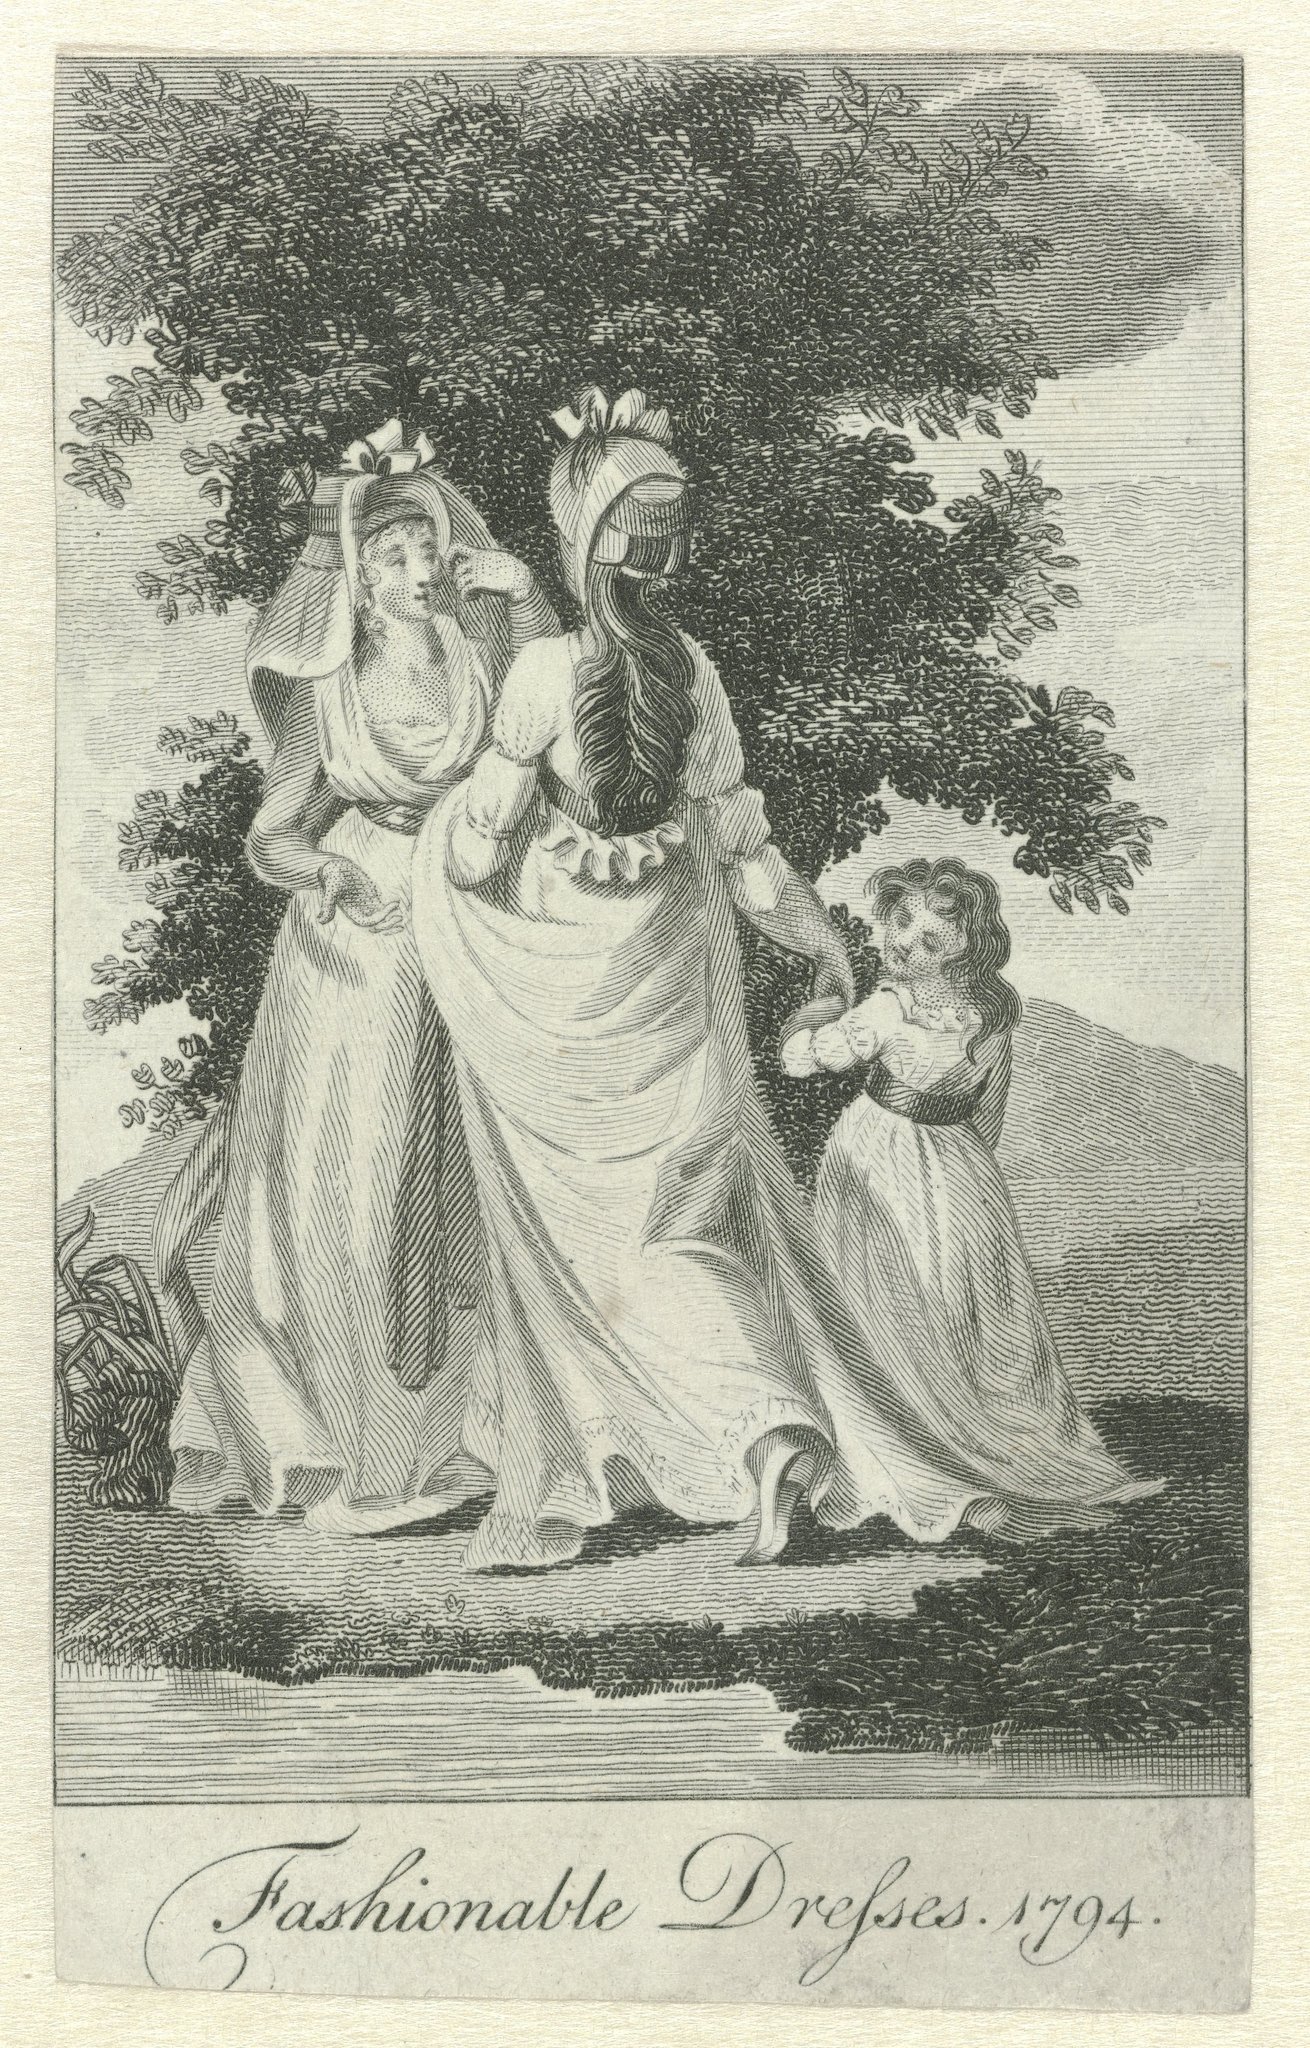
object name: fashion print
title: Fashionable Dresses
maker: Anonymous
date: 1794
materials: paper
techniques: engraving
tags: clothing for the upper part of the body (+ women's clothes), calendar, almanac, head-gear (+ women's clothes), fashion plates, dress, gown (+ women's clothes), dress, gown (+ girls' clothes)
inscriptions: title: ‘Fashionable Dresses. 1794.’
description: Engels almanakprentje uit 1794: staande vrouw voor een boom, gekleed in een modieuze japon met om de taille een sjerp. Op het hoofd een hoed met sluier. Rechts komt een vrouw met een meisje aanlopen, op de rug gezien, beiden gekleed in een modieuze japon met sleep. Op het hoofd een hoed met lint. De prent maakt waarschijnlijk deel uit van een Engelse almanak, 1794.